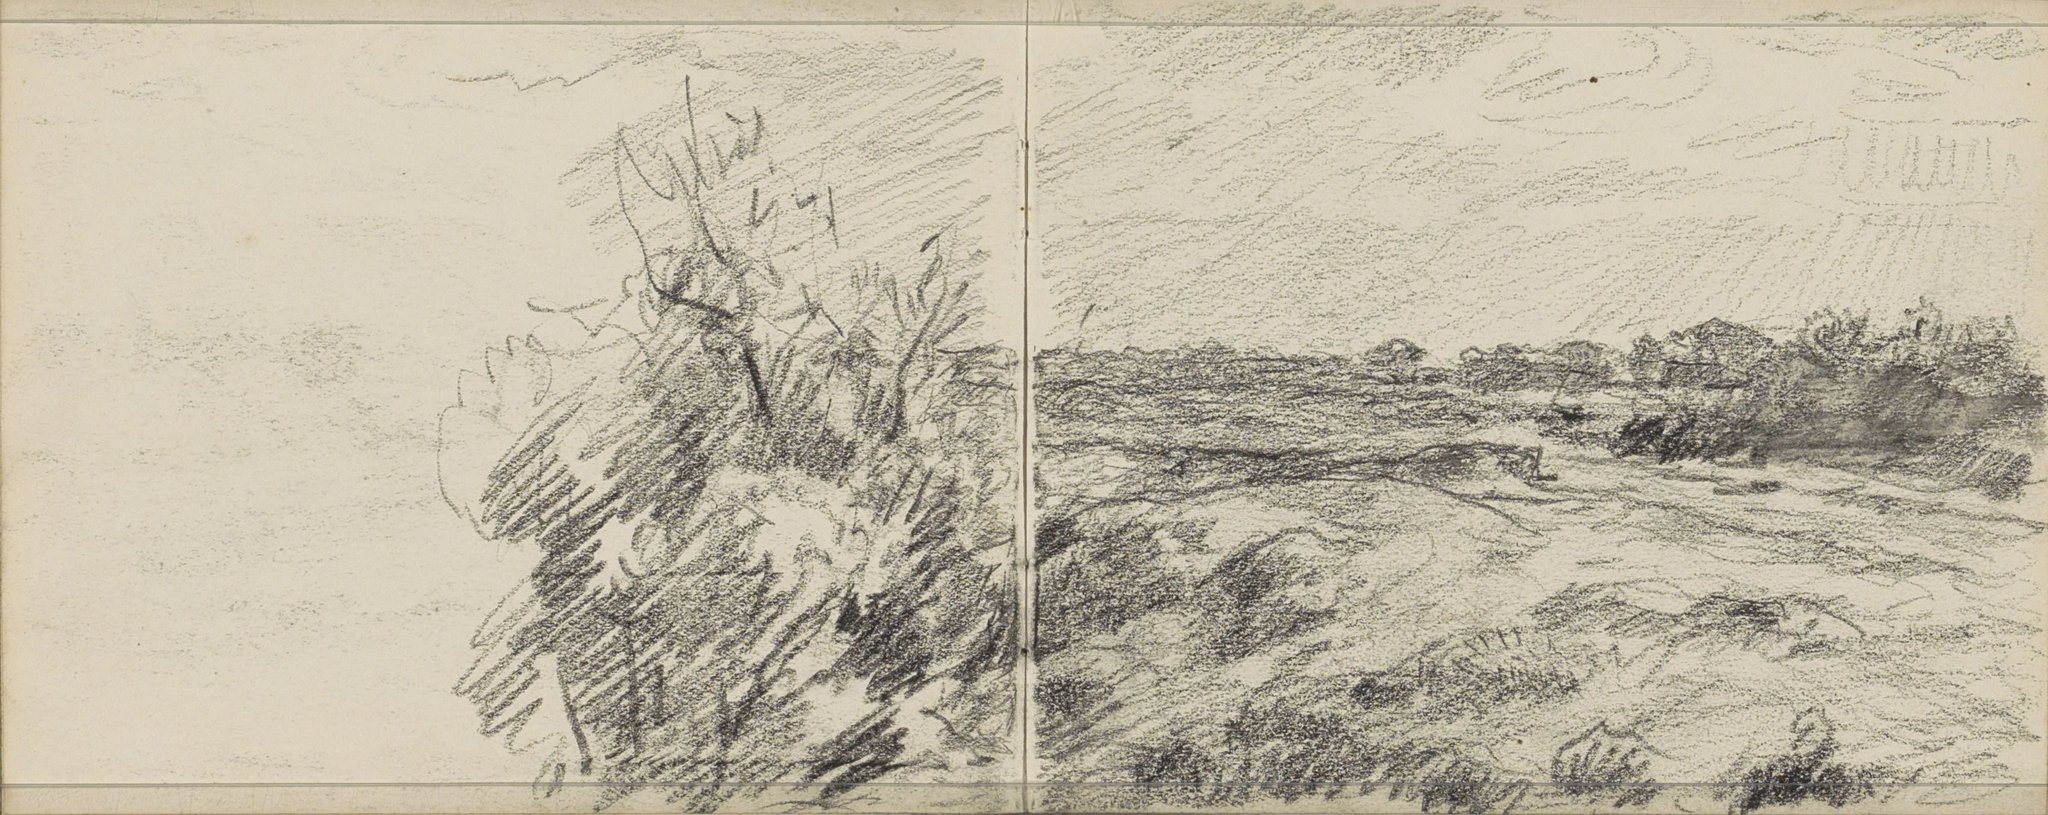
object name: sketchbook leaf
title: Landschap, mogelijk een duinlandschap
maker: johan antonie de jonge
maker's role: draughtsman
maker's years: 1864-1927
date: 1881-1927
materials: chalk, paper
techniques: stumping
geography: south holland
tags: dunes (sea not visible); in the dunes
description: Landschap, mogelijk een duinlandschap. Blad 1 verso en blad 2 recto uit een schetsboek met 29 bladen.